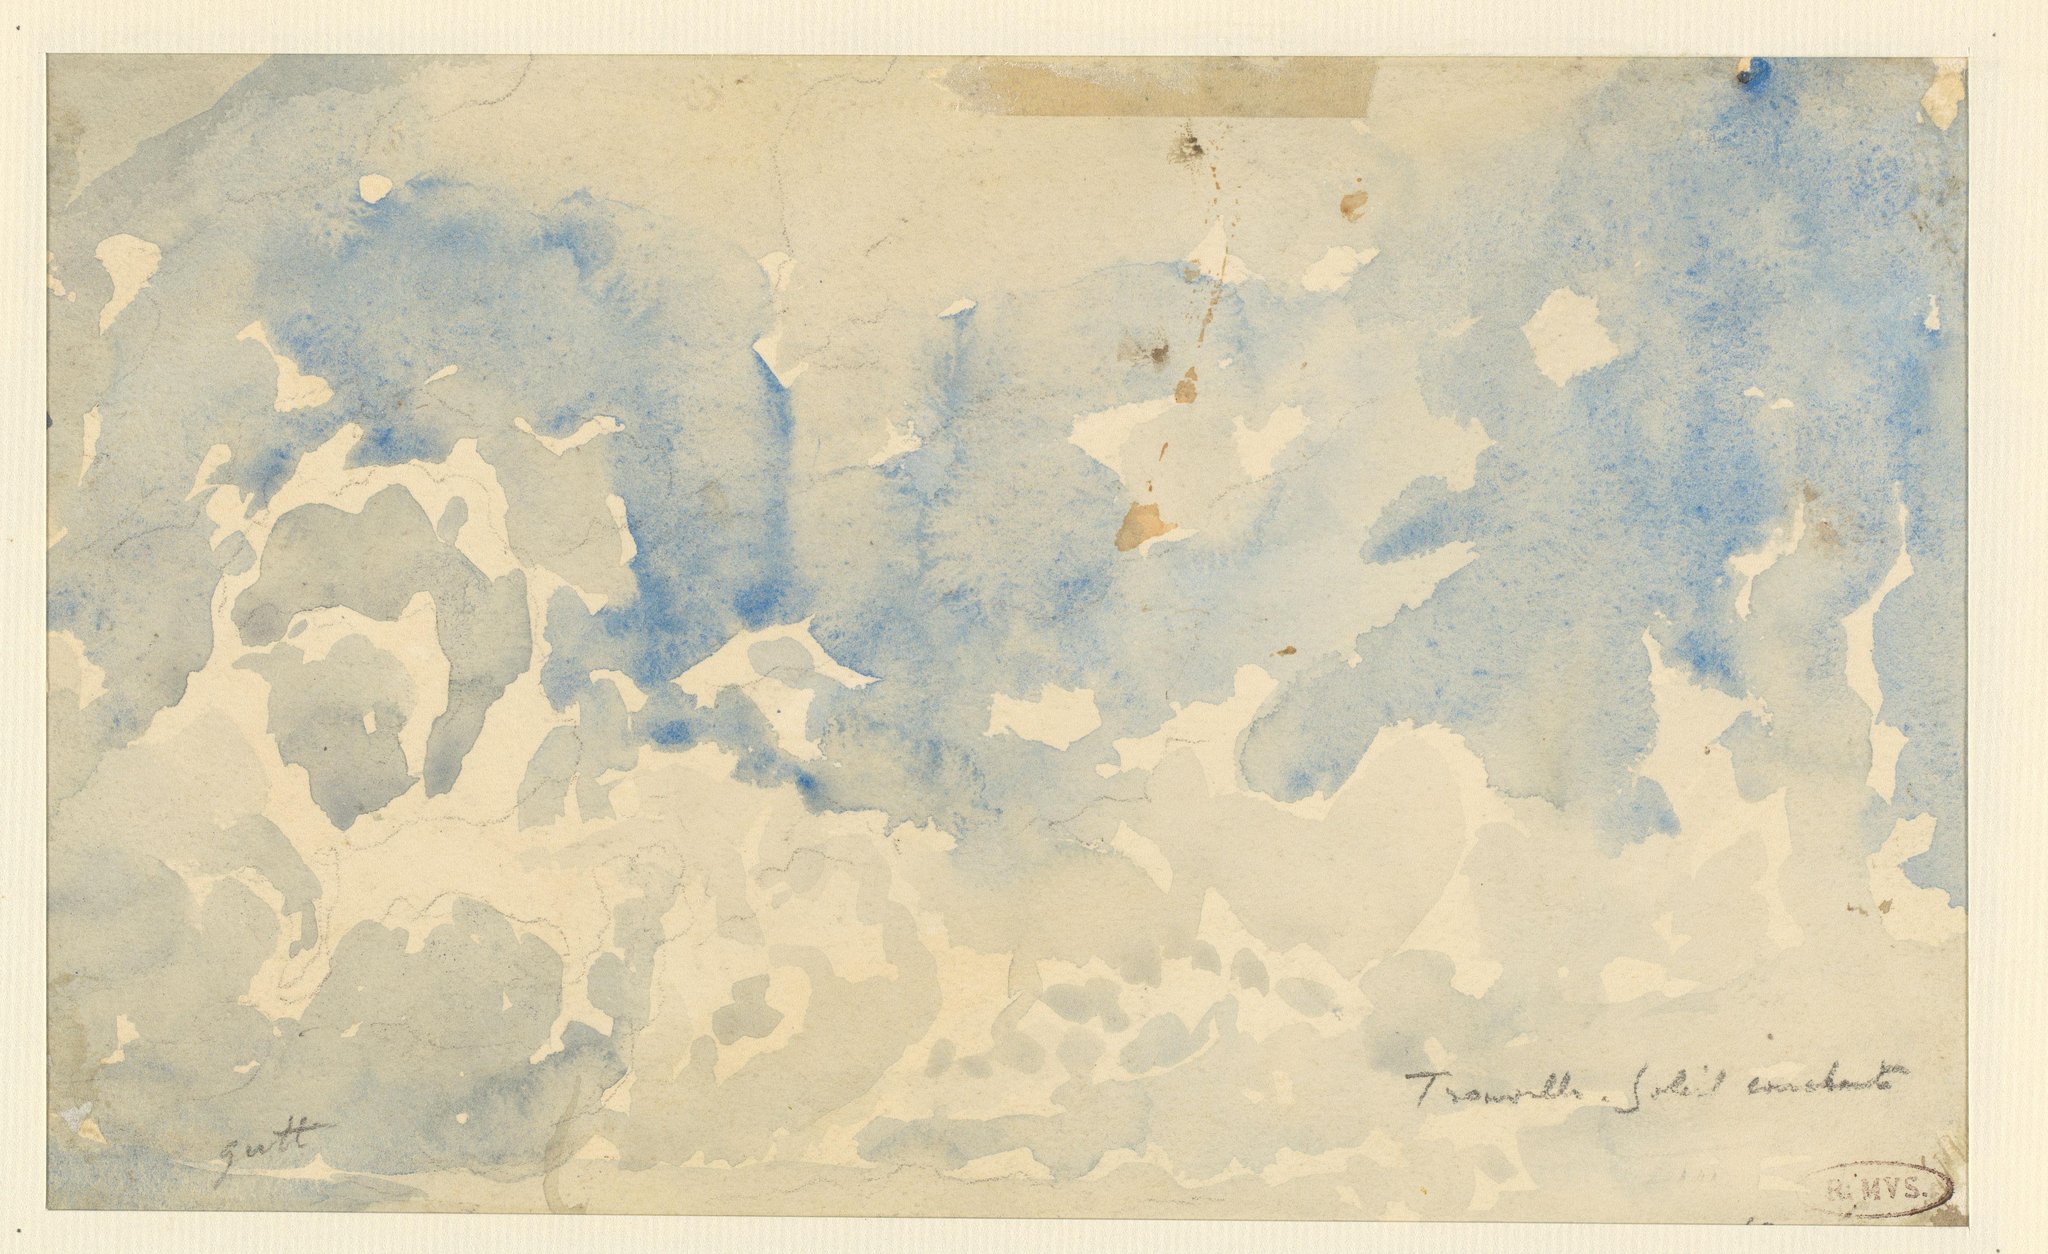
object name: drawing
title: Wolkenstudies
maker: paul huet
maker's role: draughtsman, print maker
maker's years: 1803-1869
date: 1813-1869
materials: chalk, paper, pencil, watercolor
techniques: brush